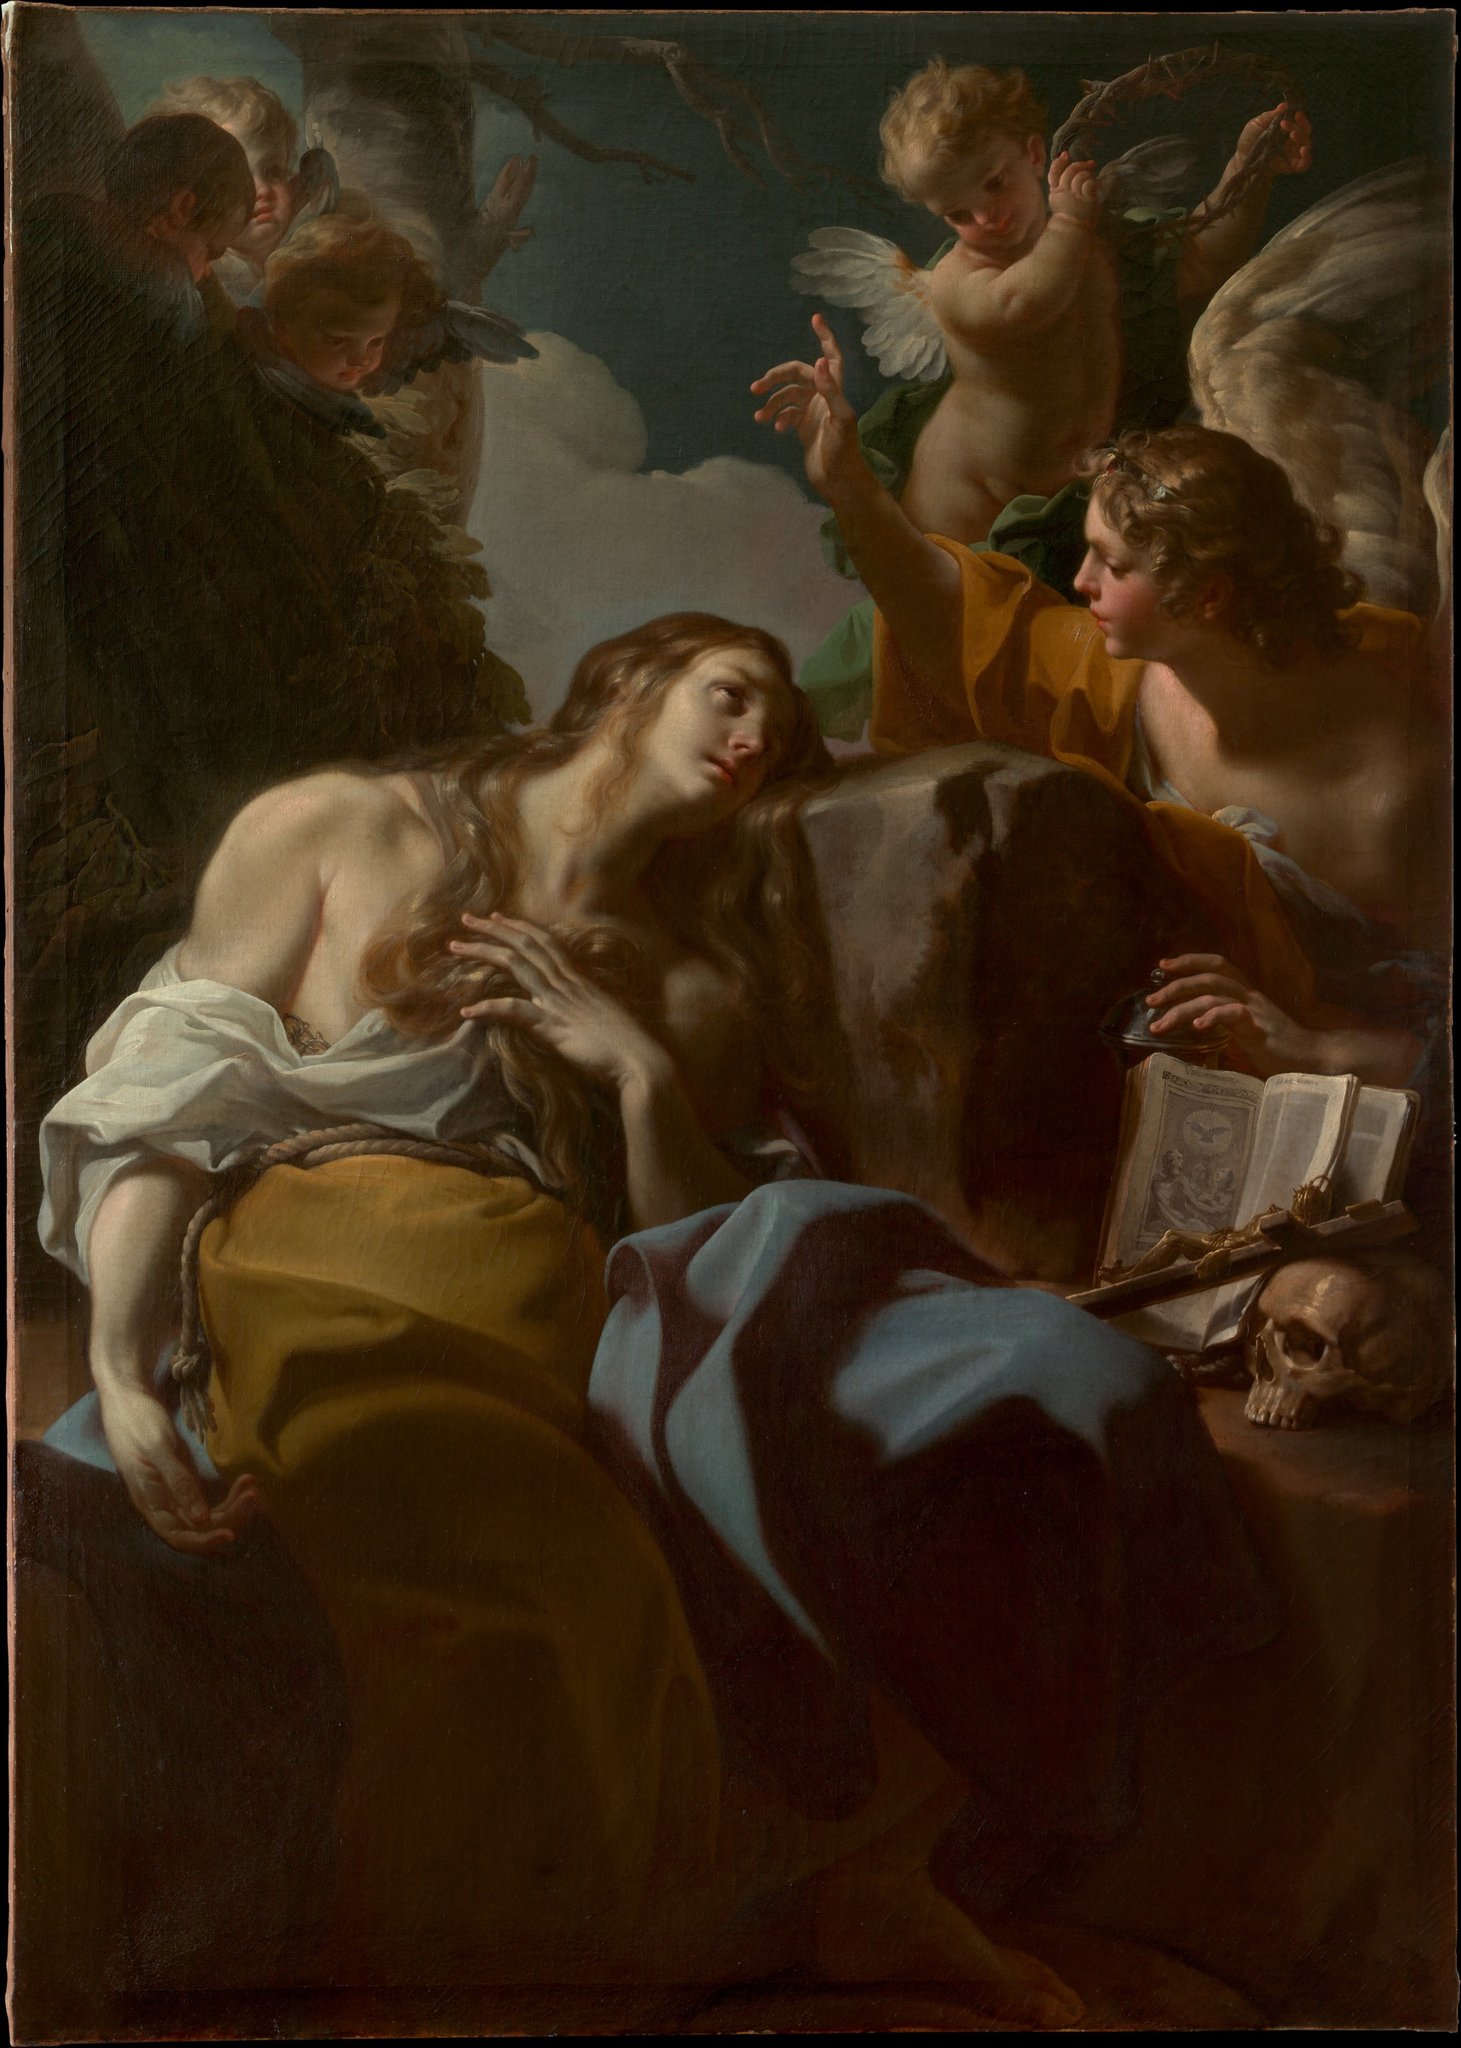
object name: painting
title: The Penitent Magdalen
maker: corrado giaquinto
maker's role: artist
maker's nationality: italian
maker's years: 1703-1766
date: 1750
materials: canvas, oil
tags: skulls,angels,mary magdalene